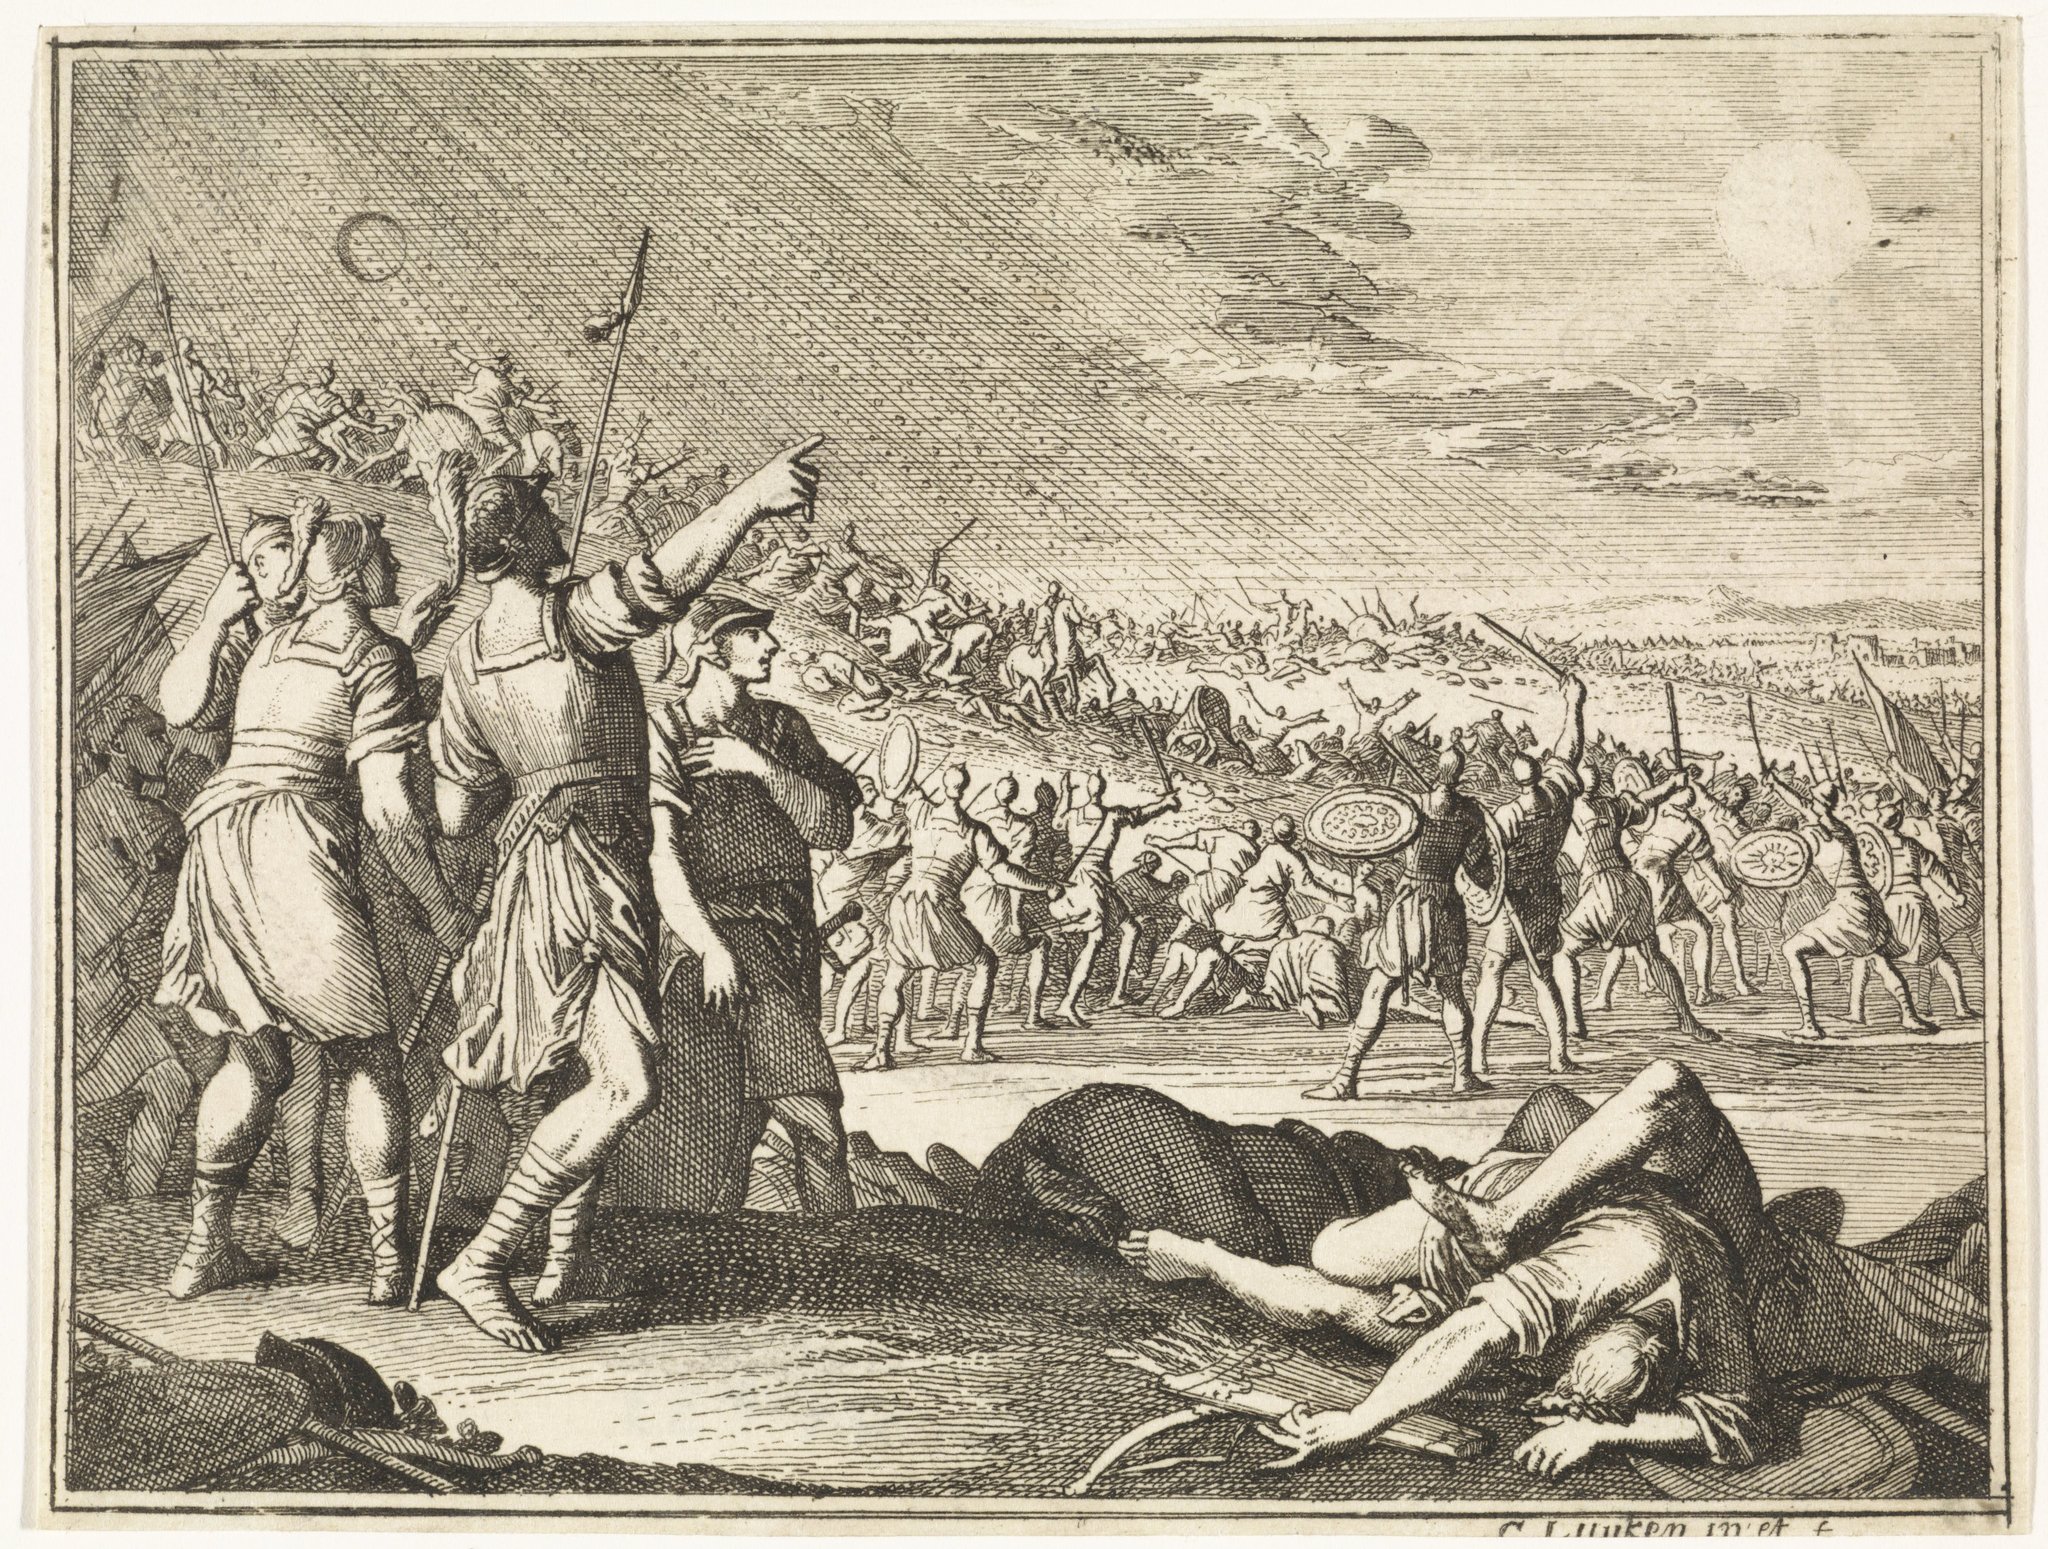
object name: print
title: Jozua beveelt de zon en maan om stil te staan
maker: caspar luyken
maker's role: draughtsman, print maker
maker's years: 1672-1708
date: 1712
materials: paper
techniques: etching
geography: amsterdam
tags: joshua orders the sun and the moon to stand still over gibeon and aijalon until the amorites who had besieged the city of gibeon are routed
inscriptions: number: ‘79’, collector's mark: Lugt 2228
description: Illustratie uit: Luyken, Jan. De schriftuurlyke geschiedenissen en gelykenissen van het Oude en Nieuwe Verbond, 2 delen. Amsterdam: Wed. Pieter Arentsz II en Cornelis van der Sys, 1712, dl. I.